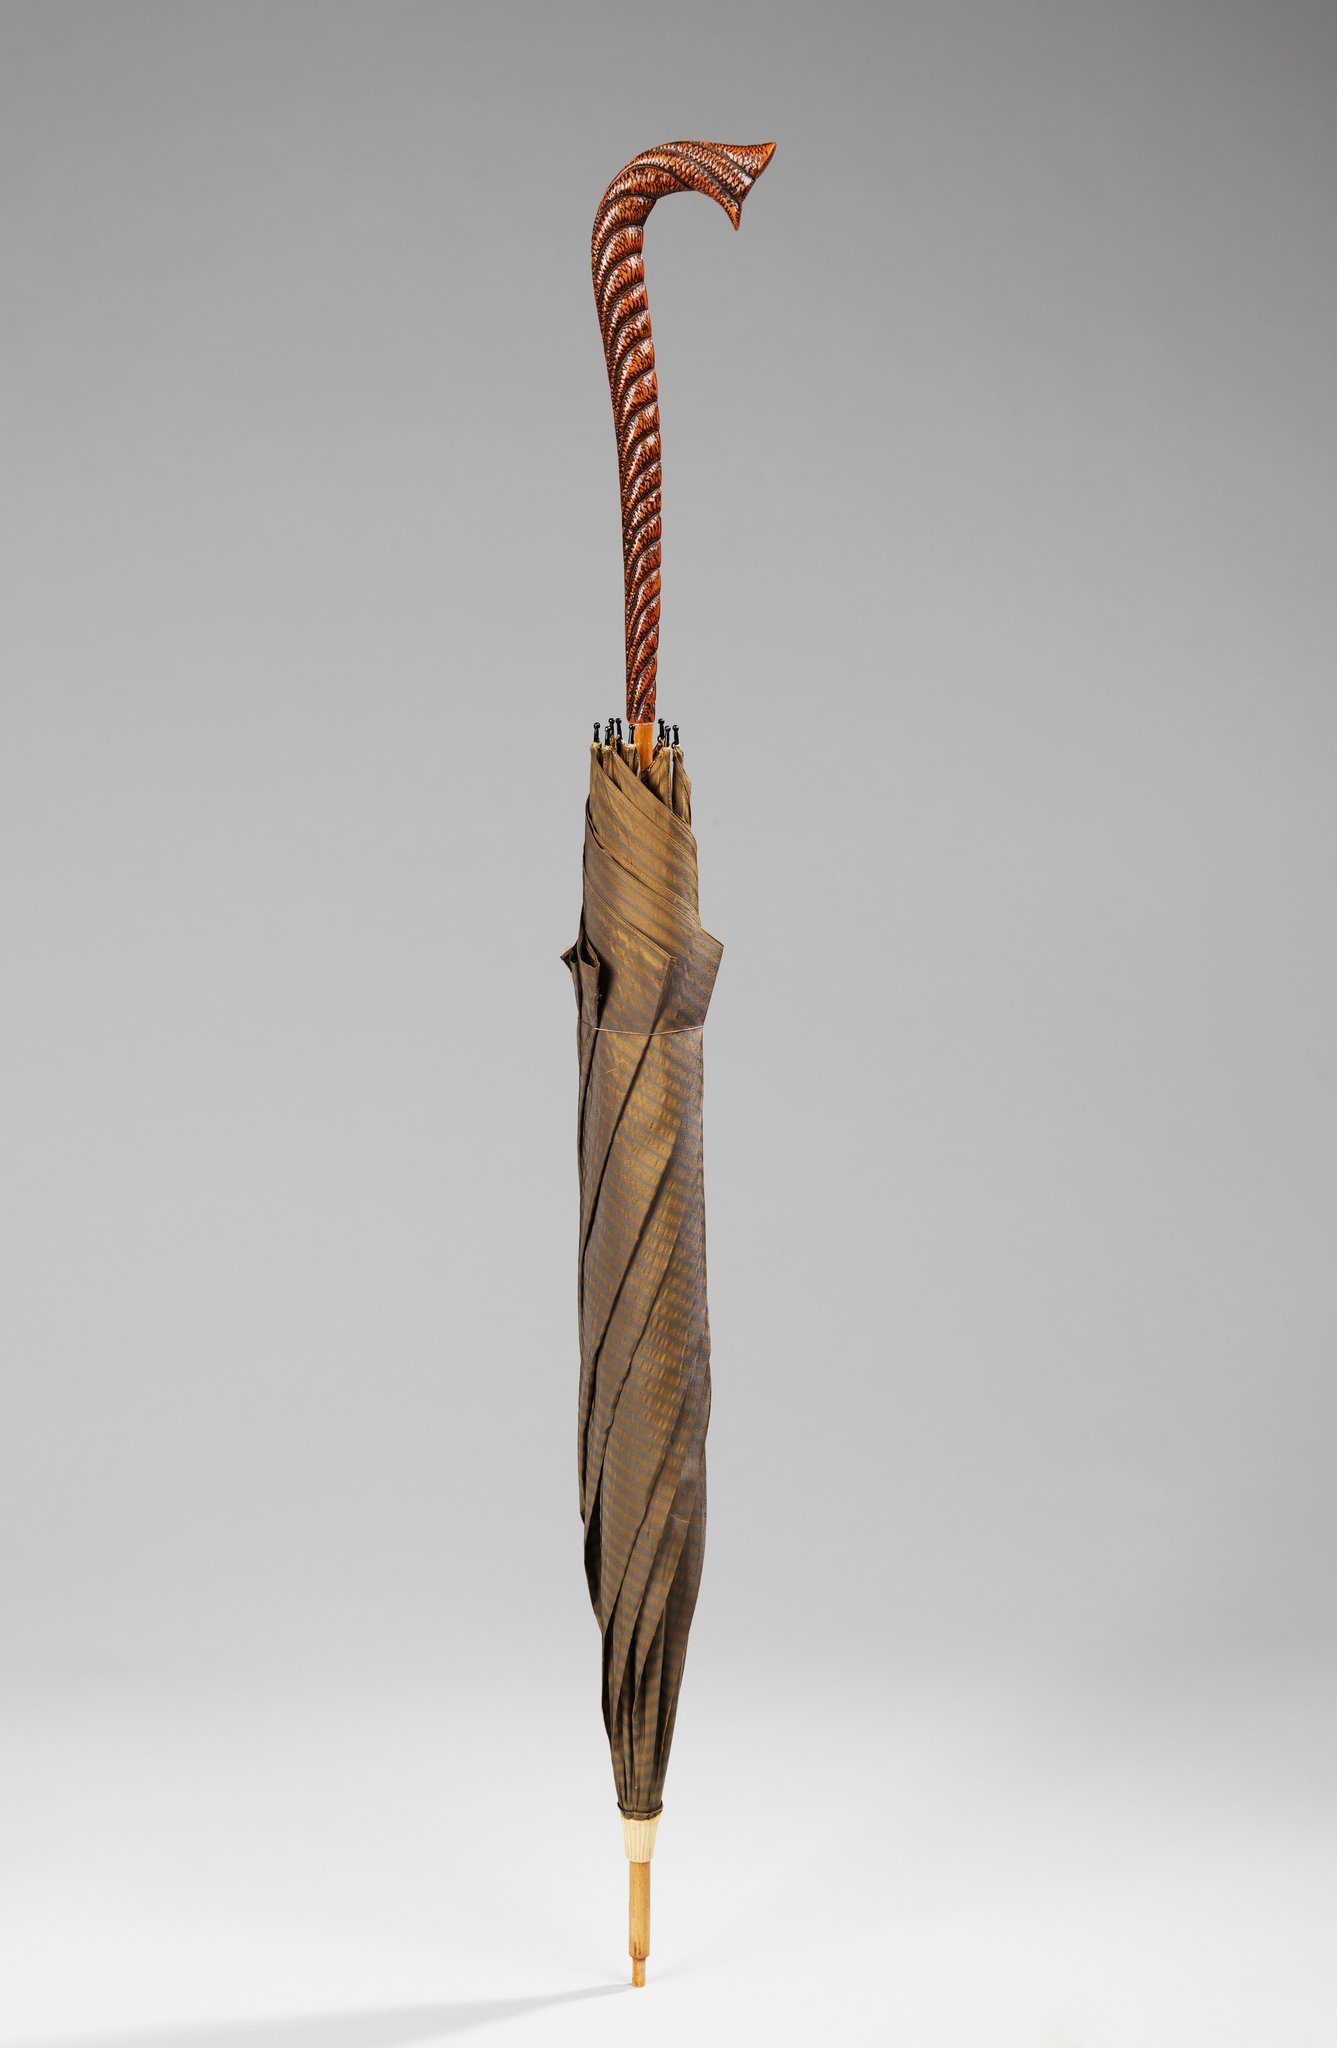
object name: umbrella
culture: american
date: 1888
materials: metal, silk, wood